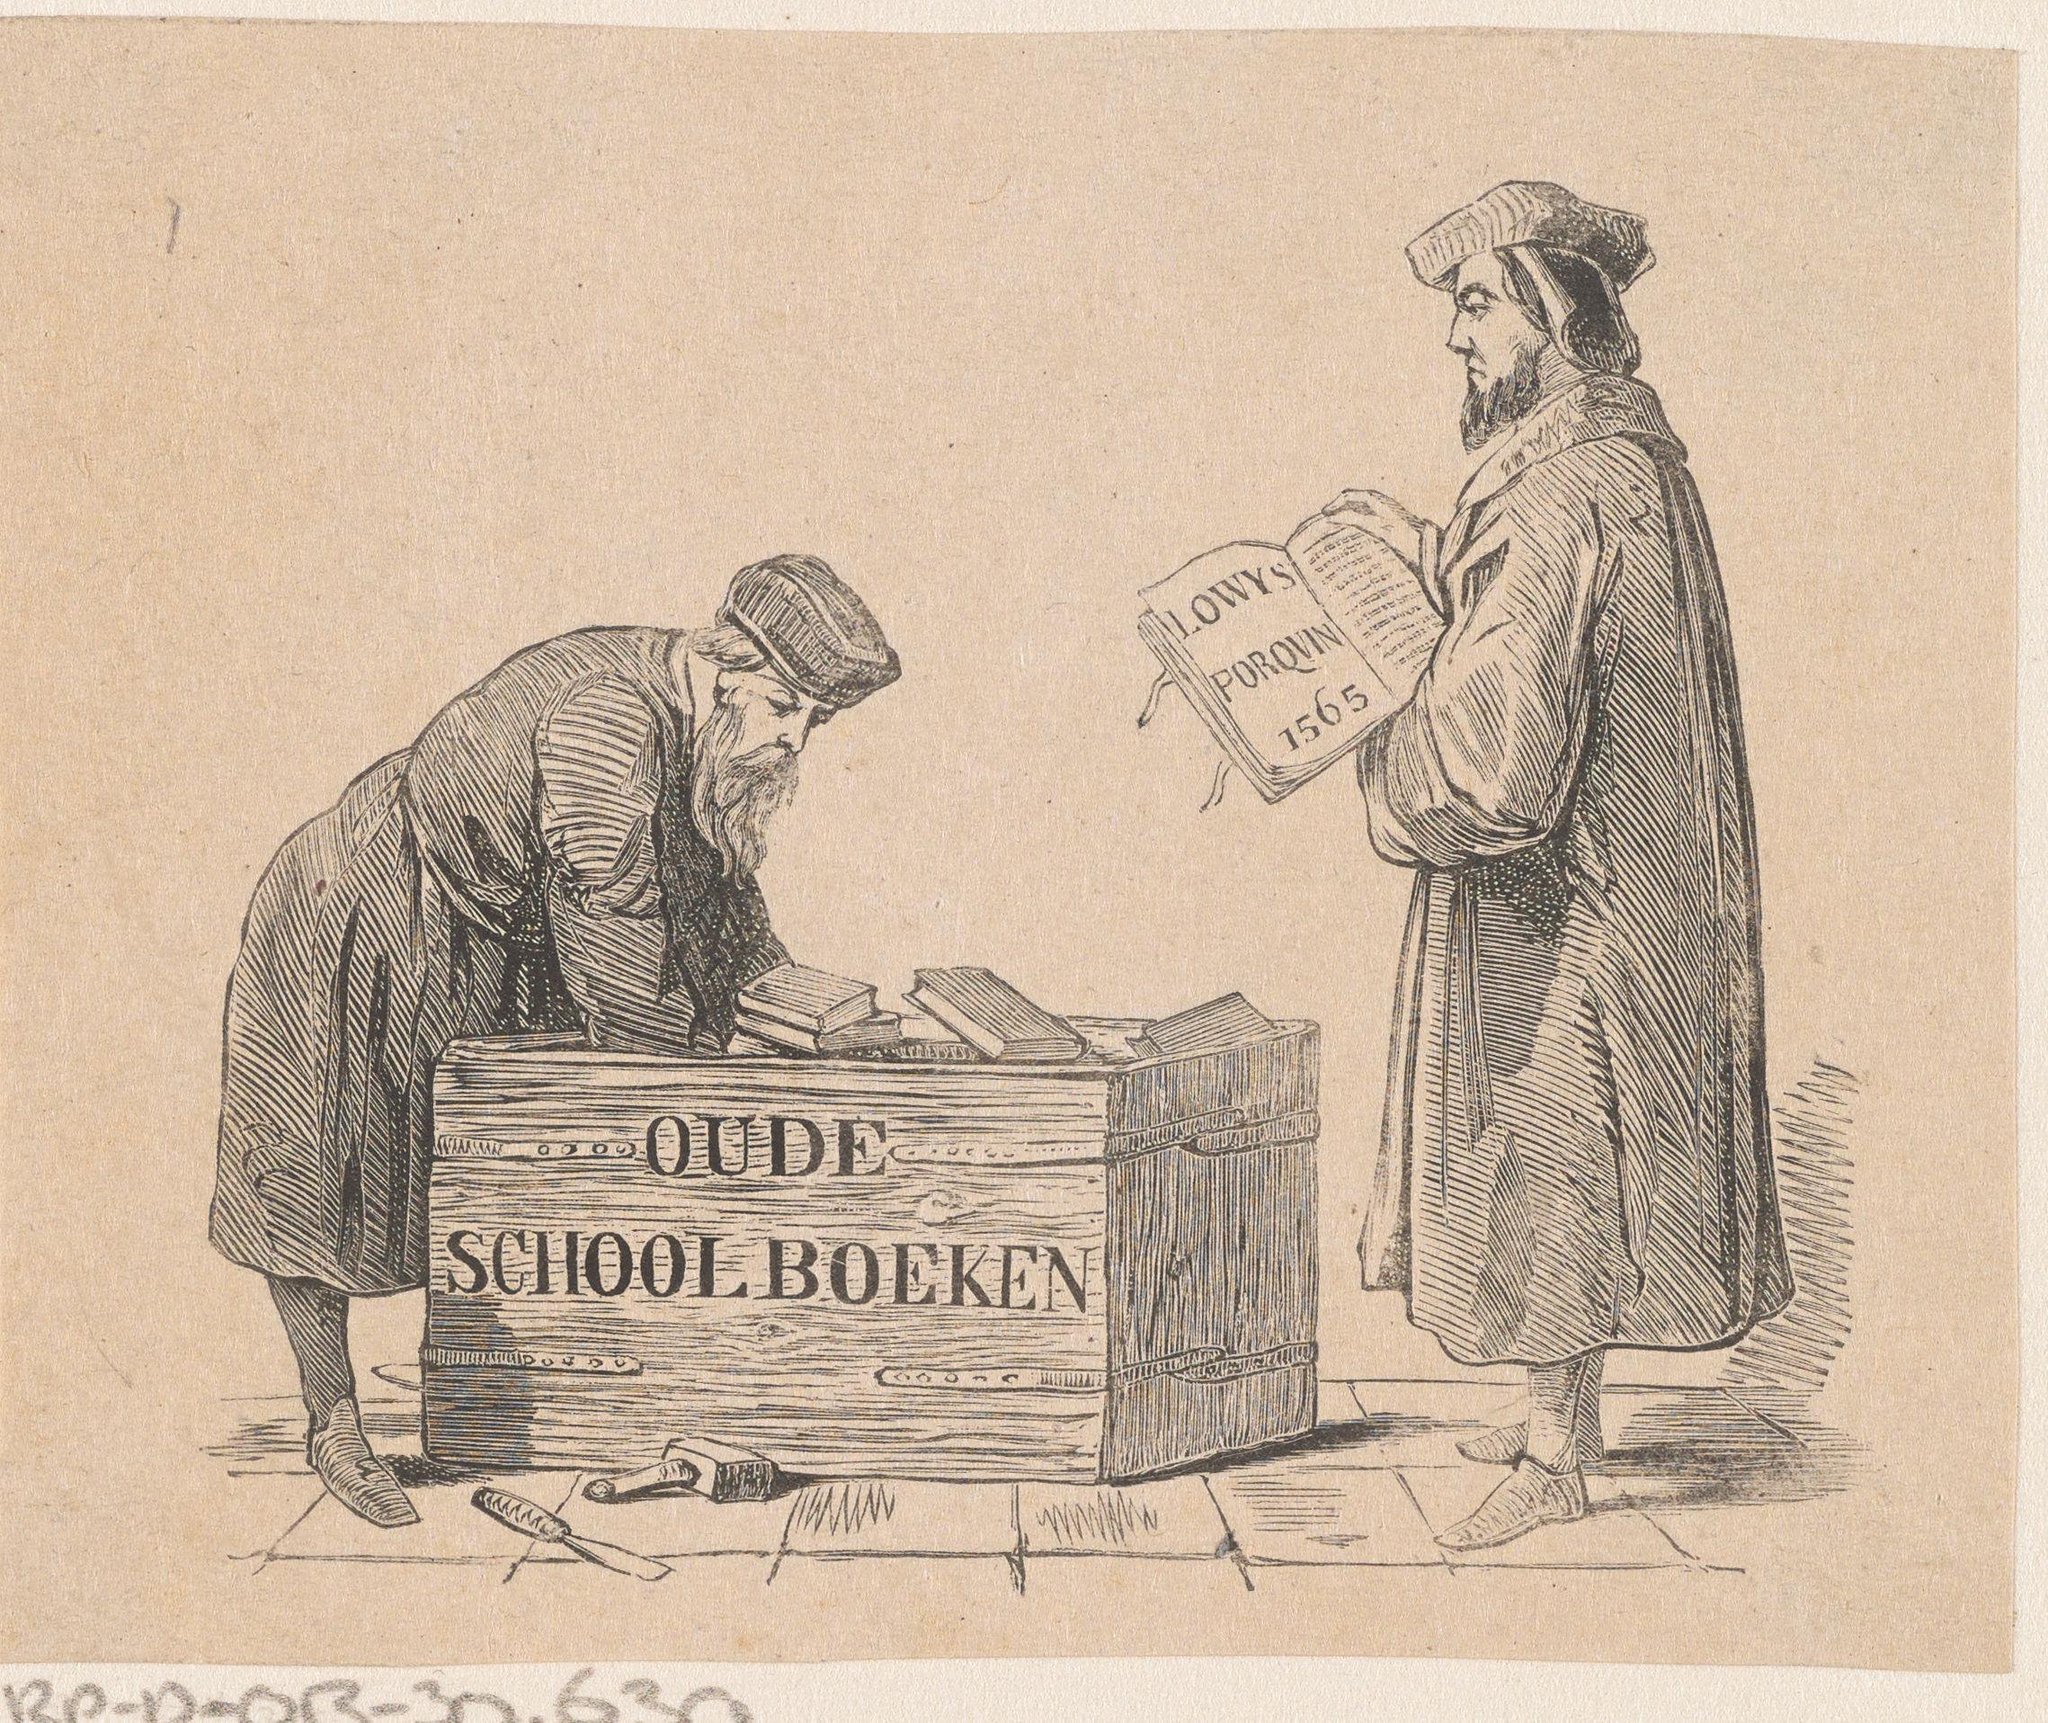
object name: print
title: Twee mannen zoekend in een kist met oude schoolboeken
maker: isaac weissenbruch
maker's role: print maker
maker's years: 1826-1912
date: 1836-1912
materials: paper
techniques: engraving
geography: netherlands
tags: adult man (+ two persons), book, scholastic education, tuition